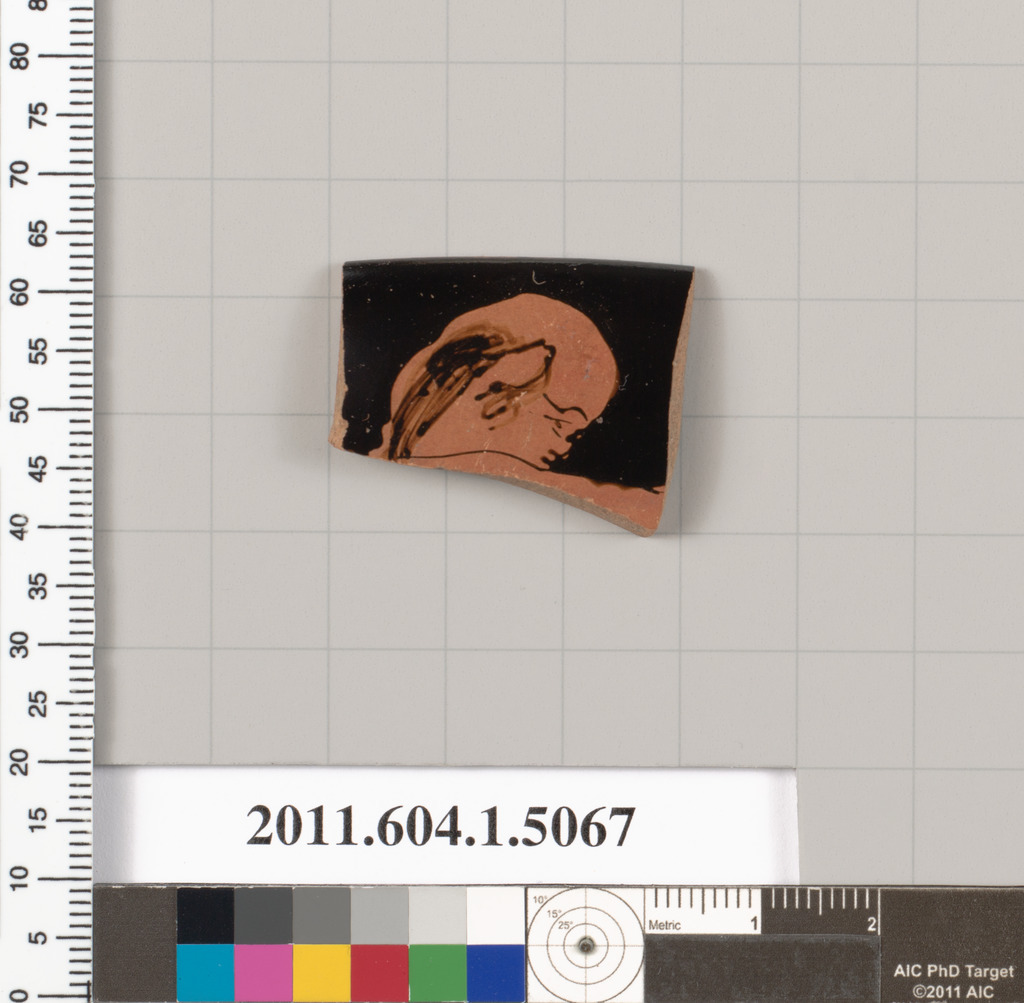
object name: kylix fragment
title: Terracotta rim fragment of a kylix (drinking cup)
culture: greek, attic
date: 467-435 BCE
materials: terracotta